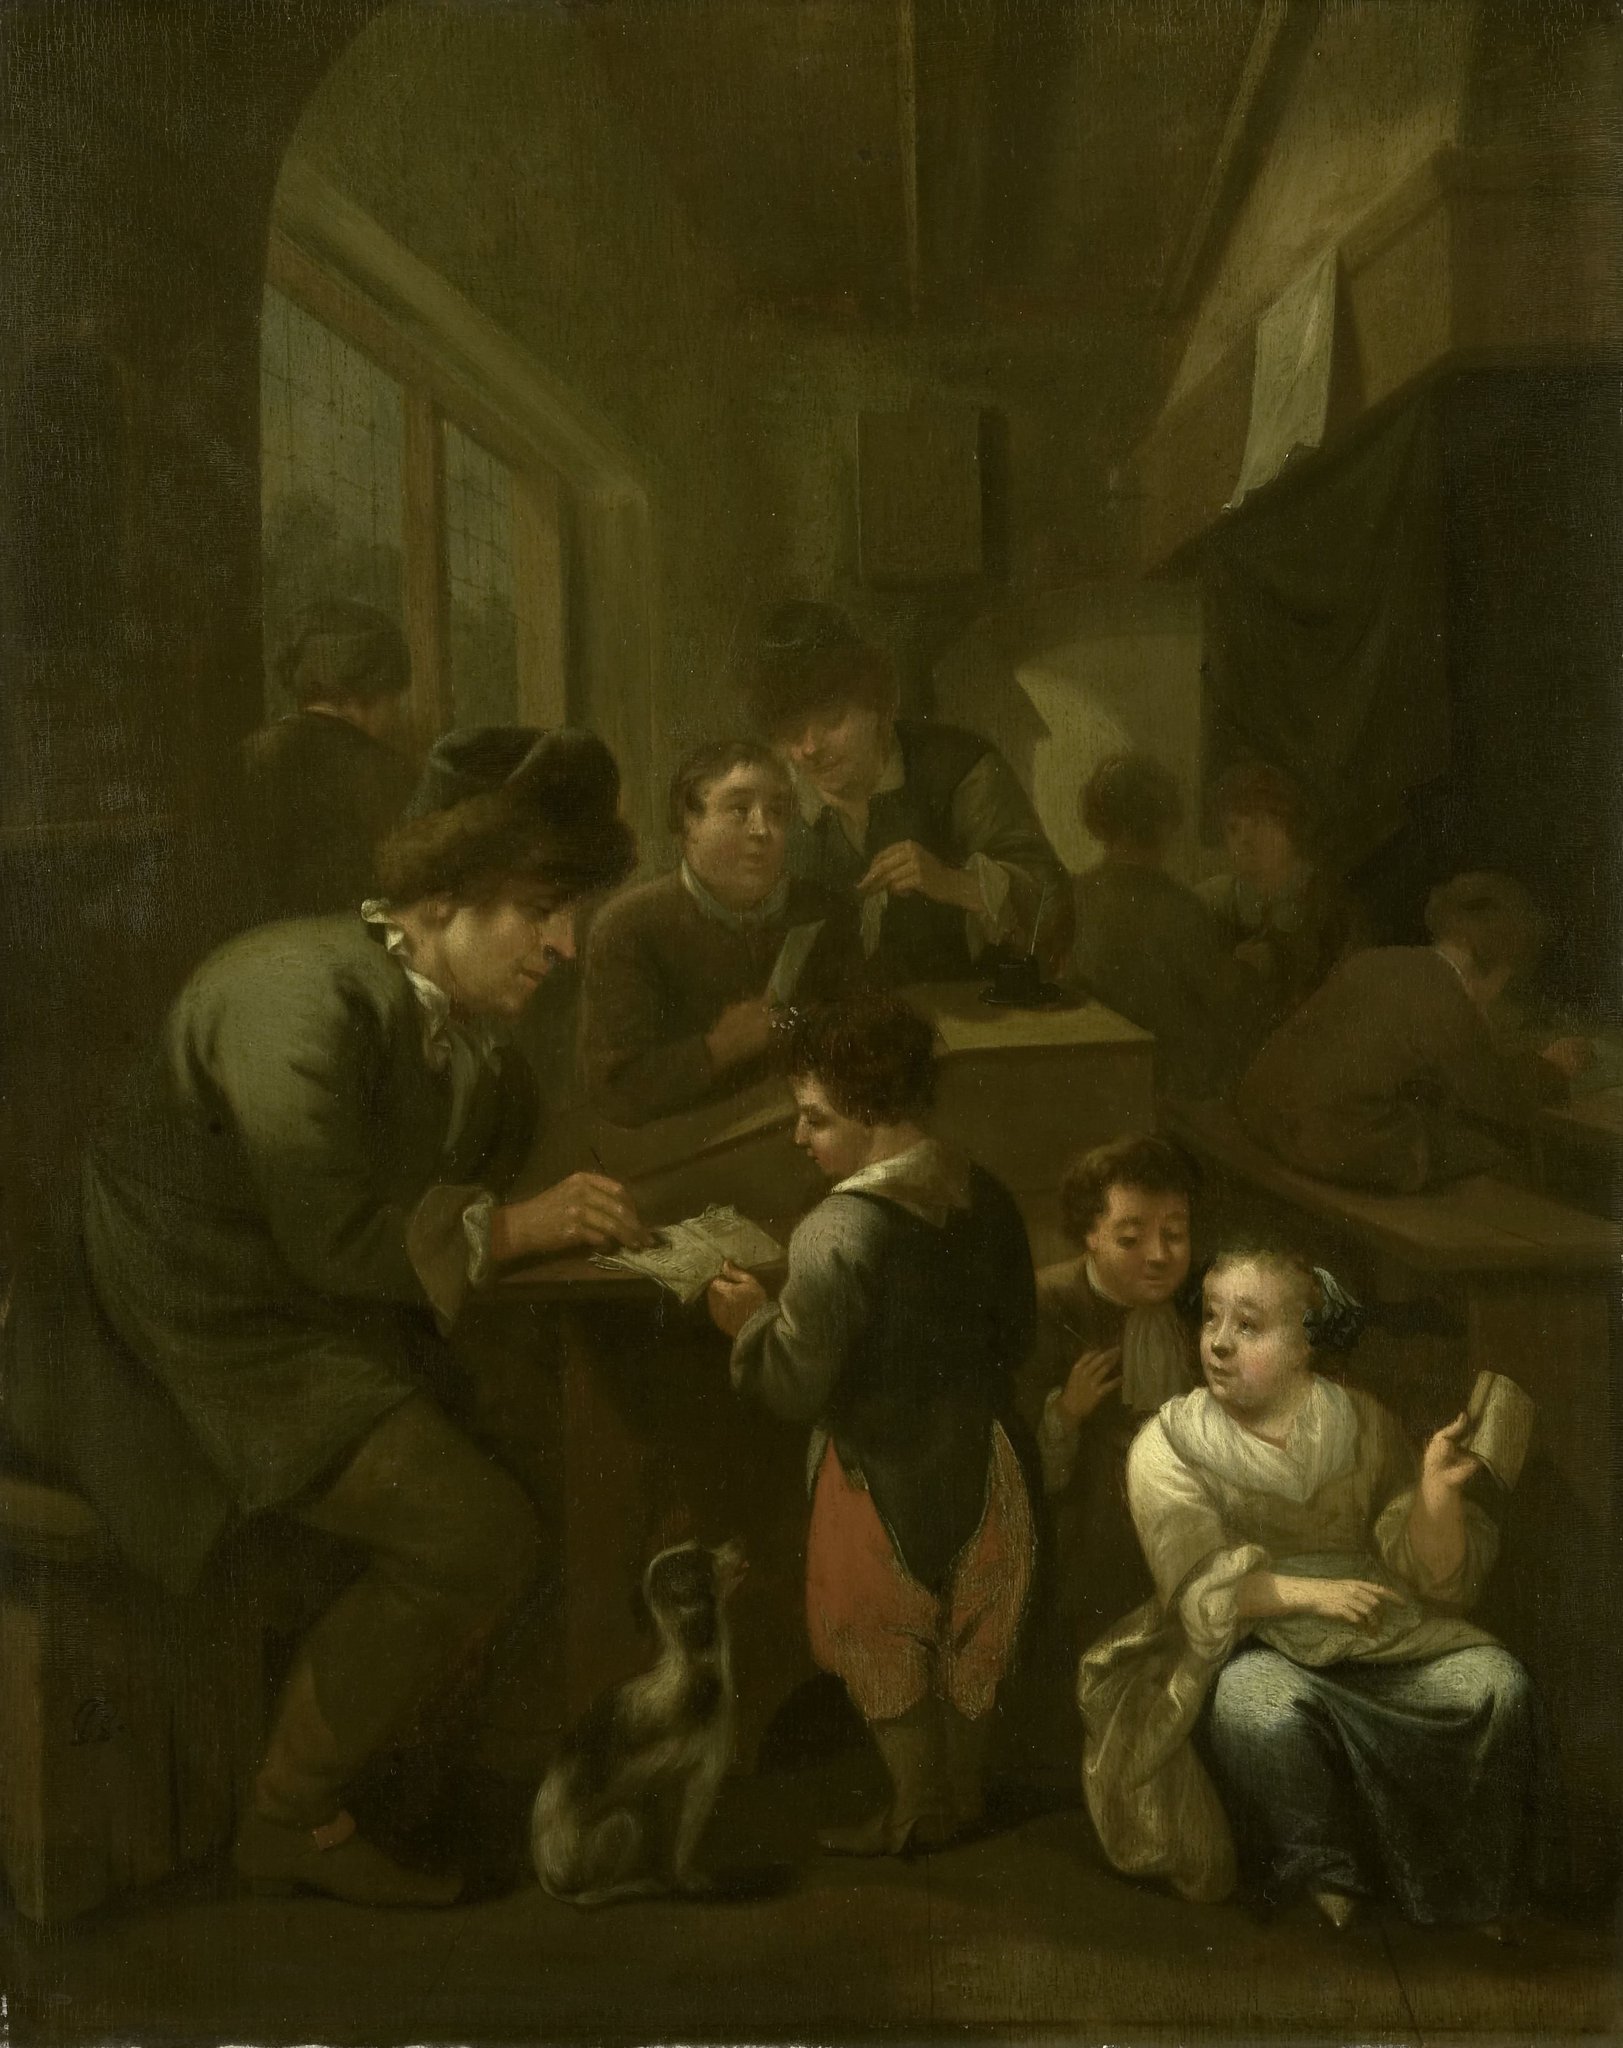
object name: painting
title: The schoolmaster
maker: bernardus van schijndel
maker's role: painter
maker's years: 1647-1709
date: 1670-1709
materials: oil, panel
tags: teacher and pupil, elementary school; class, form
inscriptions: signature: ‘BvS’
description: Een schoolmeester in zijn klaslokaal kijkt het schrift van een leerling na. Links en rechts schrijvende en lezende kinderen.